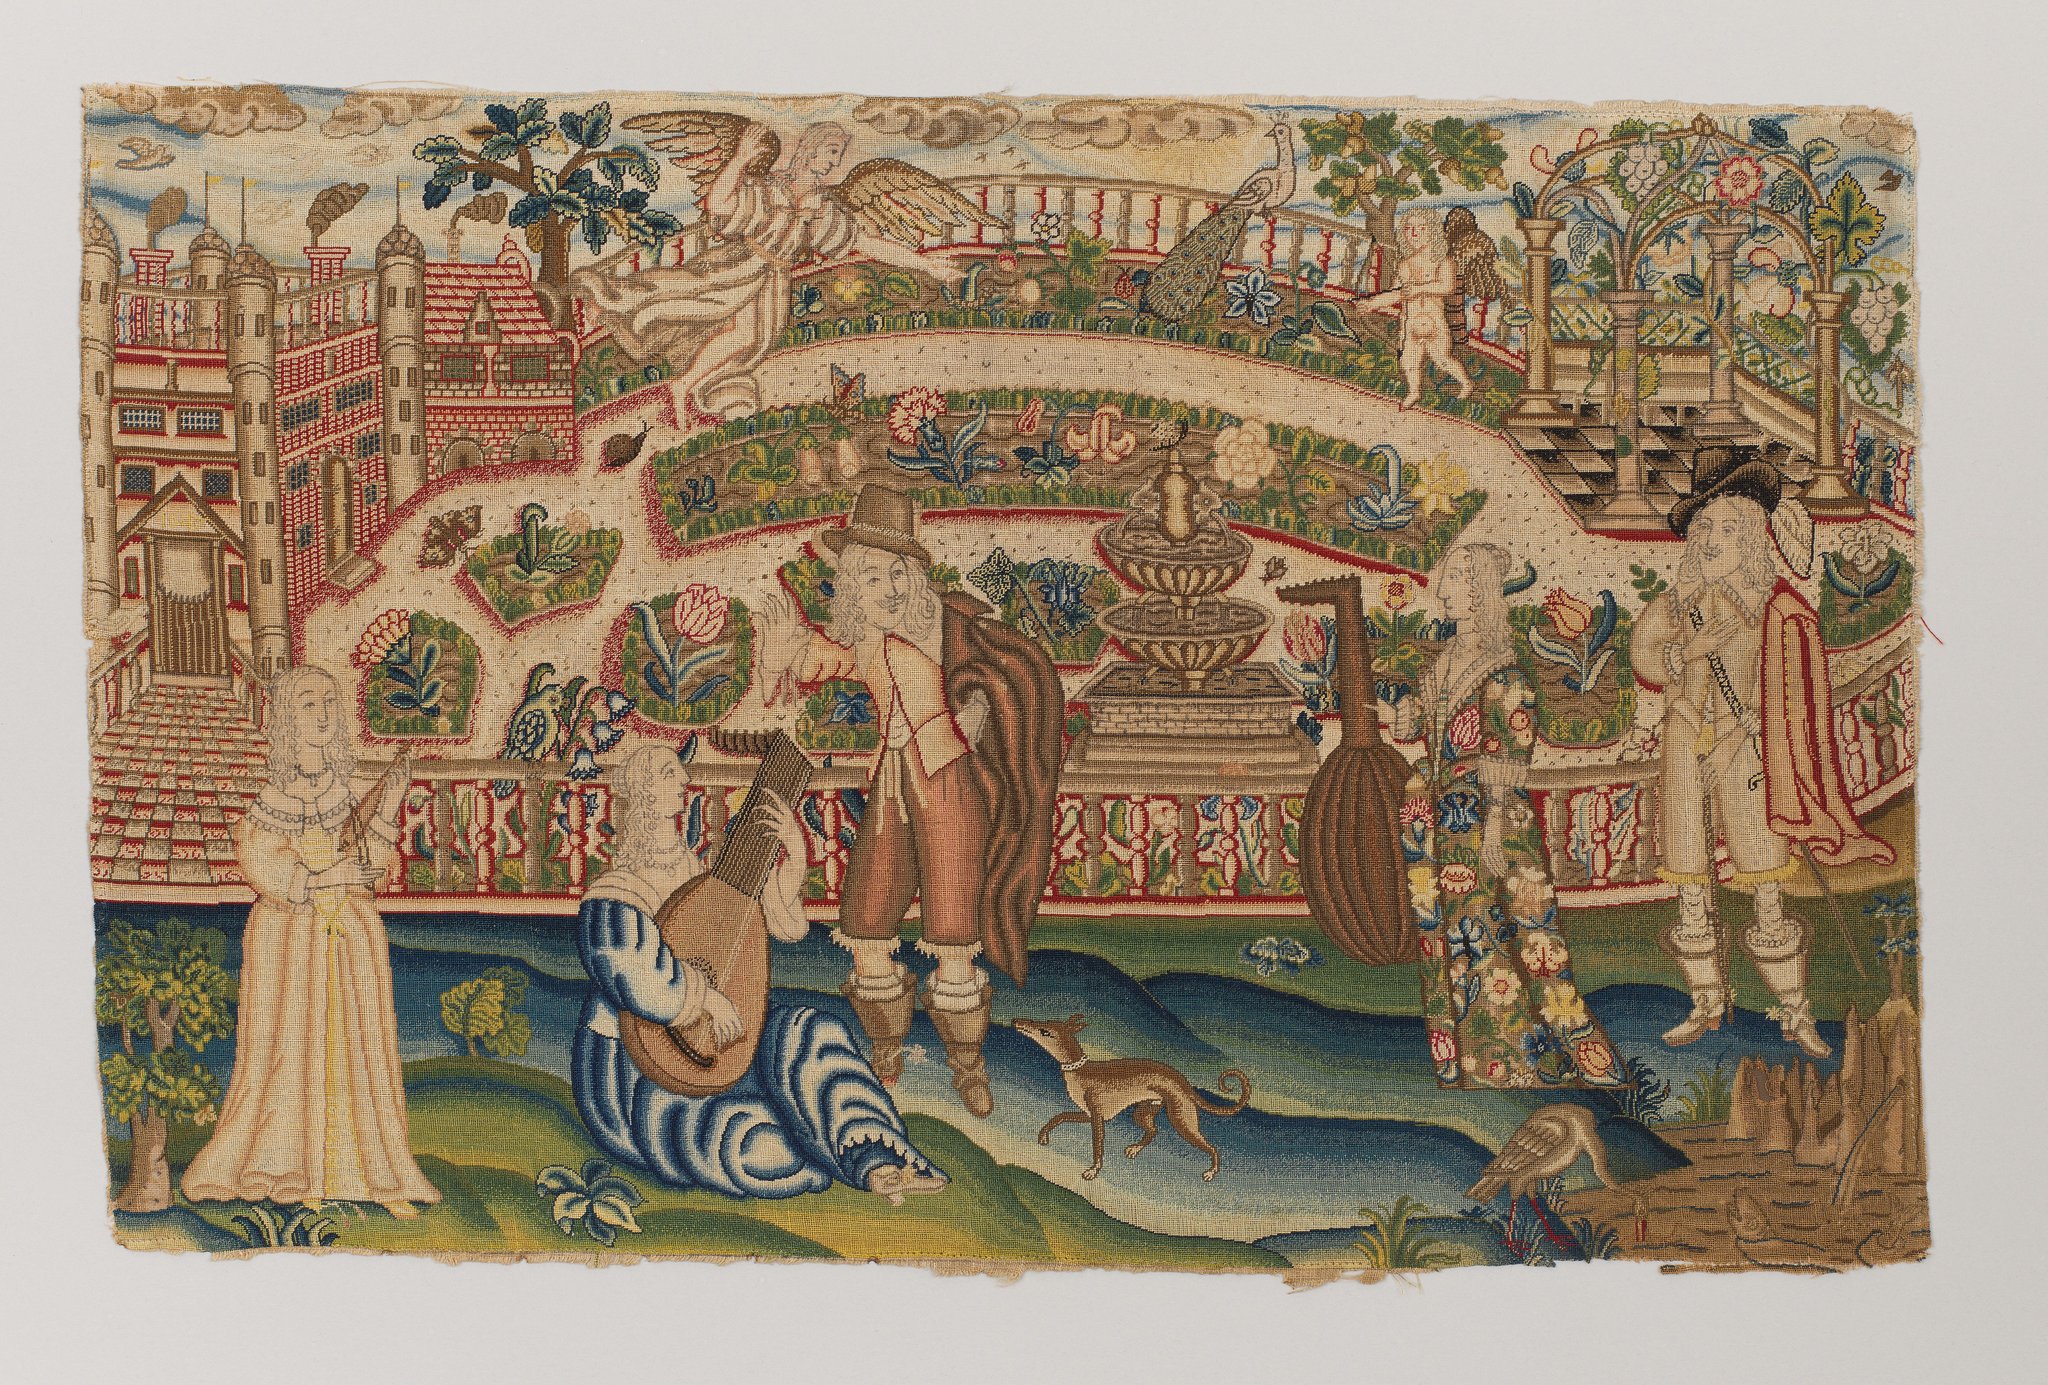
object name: embroidered picture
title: Musical Party in a Garden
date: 1647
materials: canvas, thread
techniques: stitching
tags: musical instruments,gardens,men,women,party,peacocks,dogs,musicians